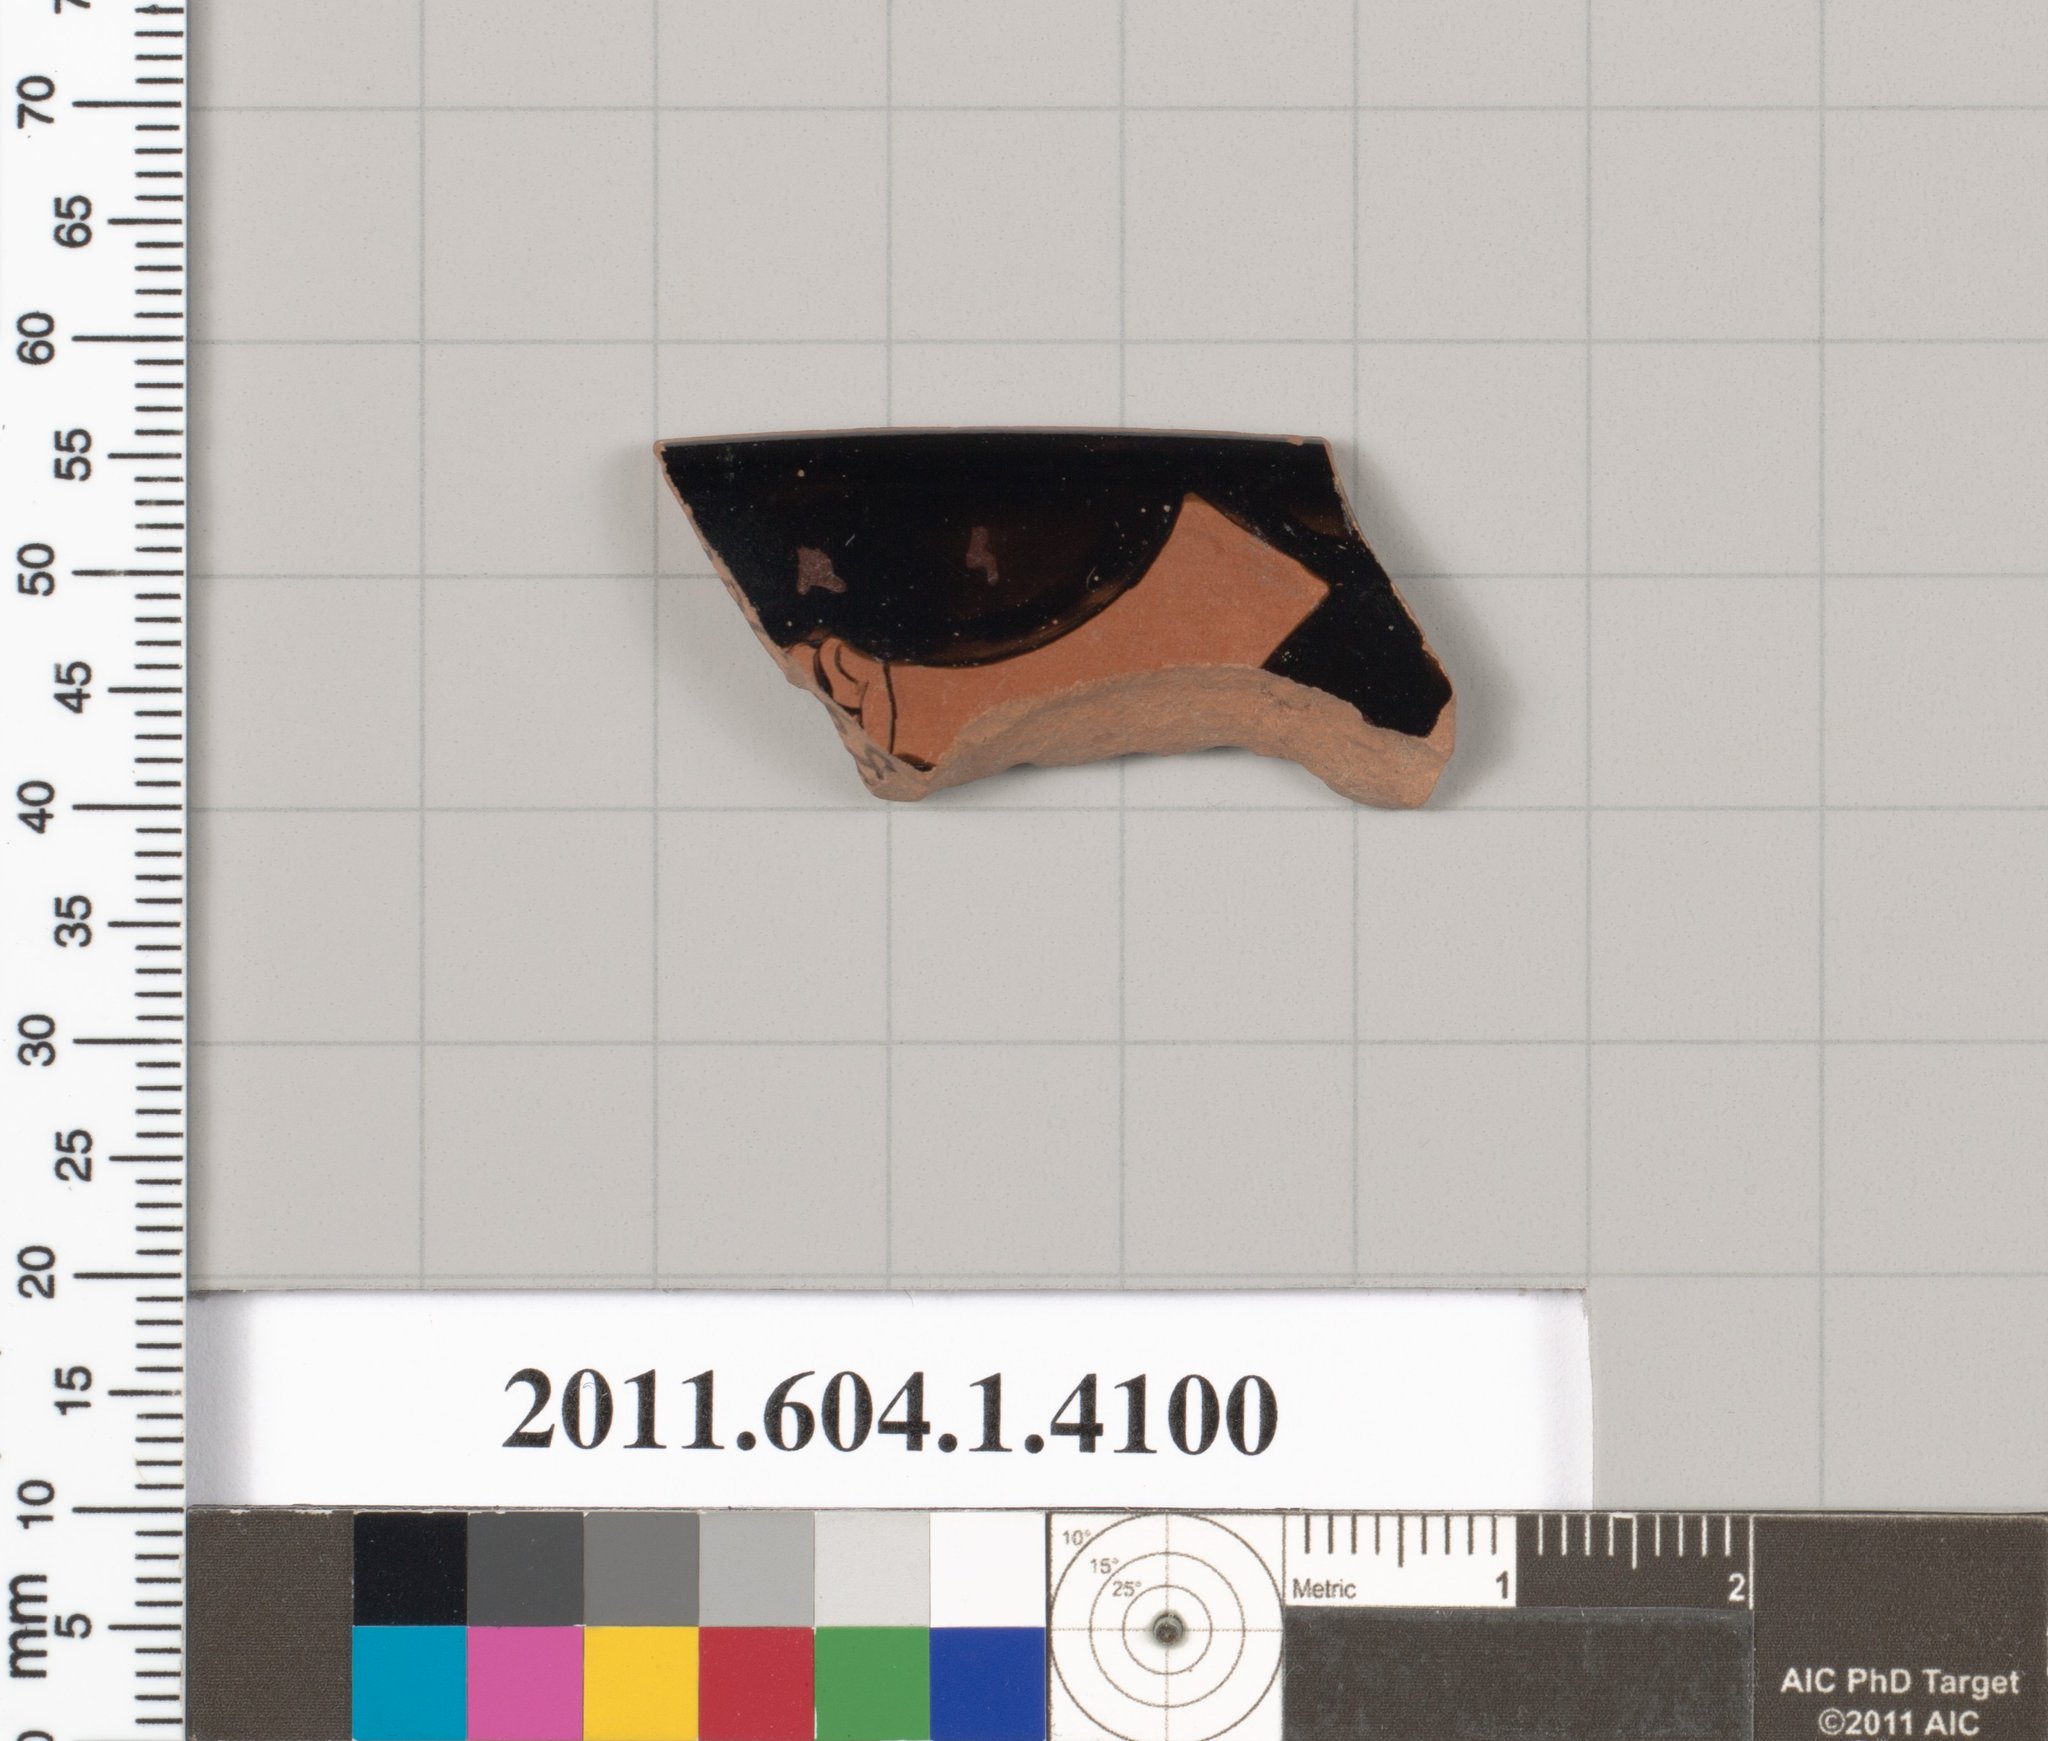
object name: kylix fragment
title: Terracotta rim fragment of a kylix (drinking cup)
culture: greek, attic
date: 520-500 BCE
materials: terracotta